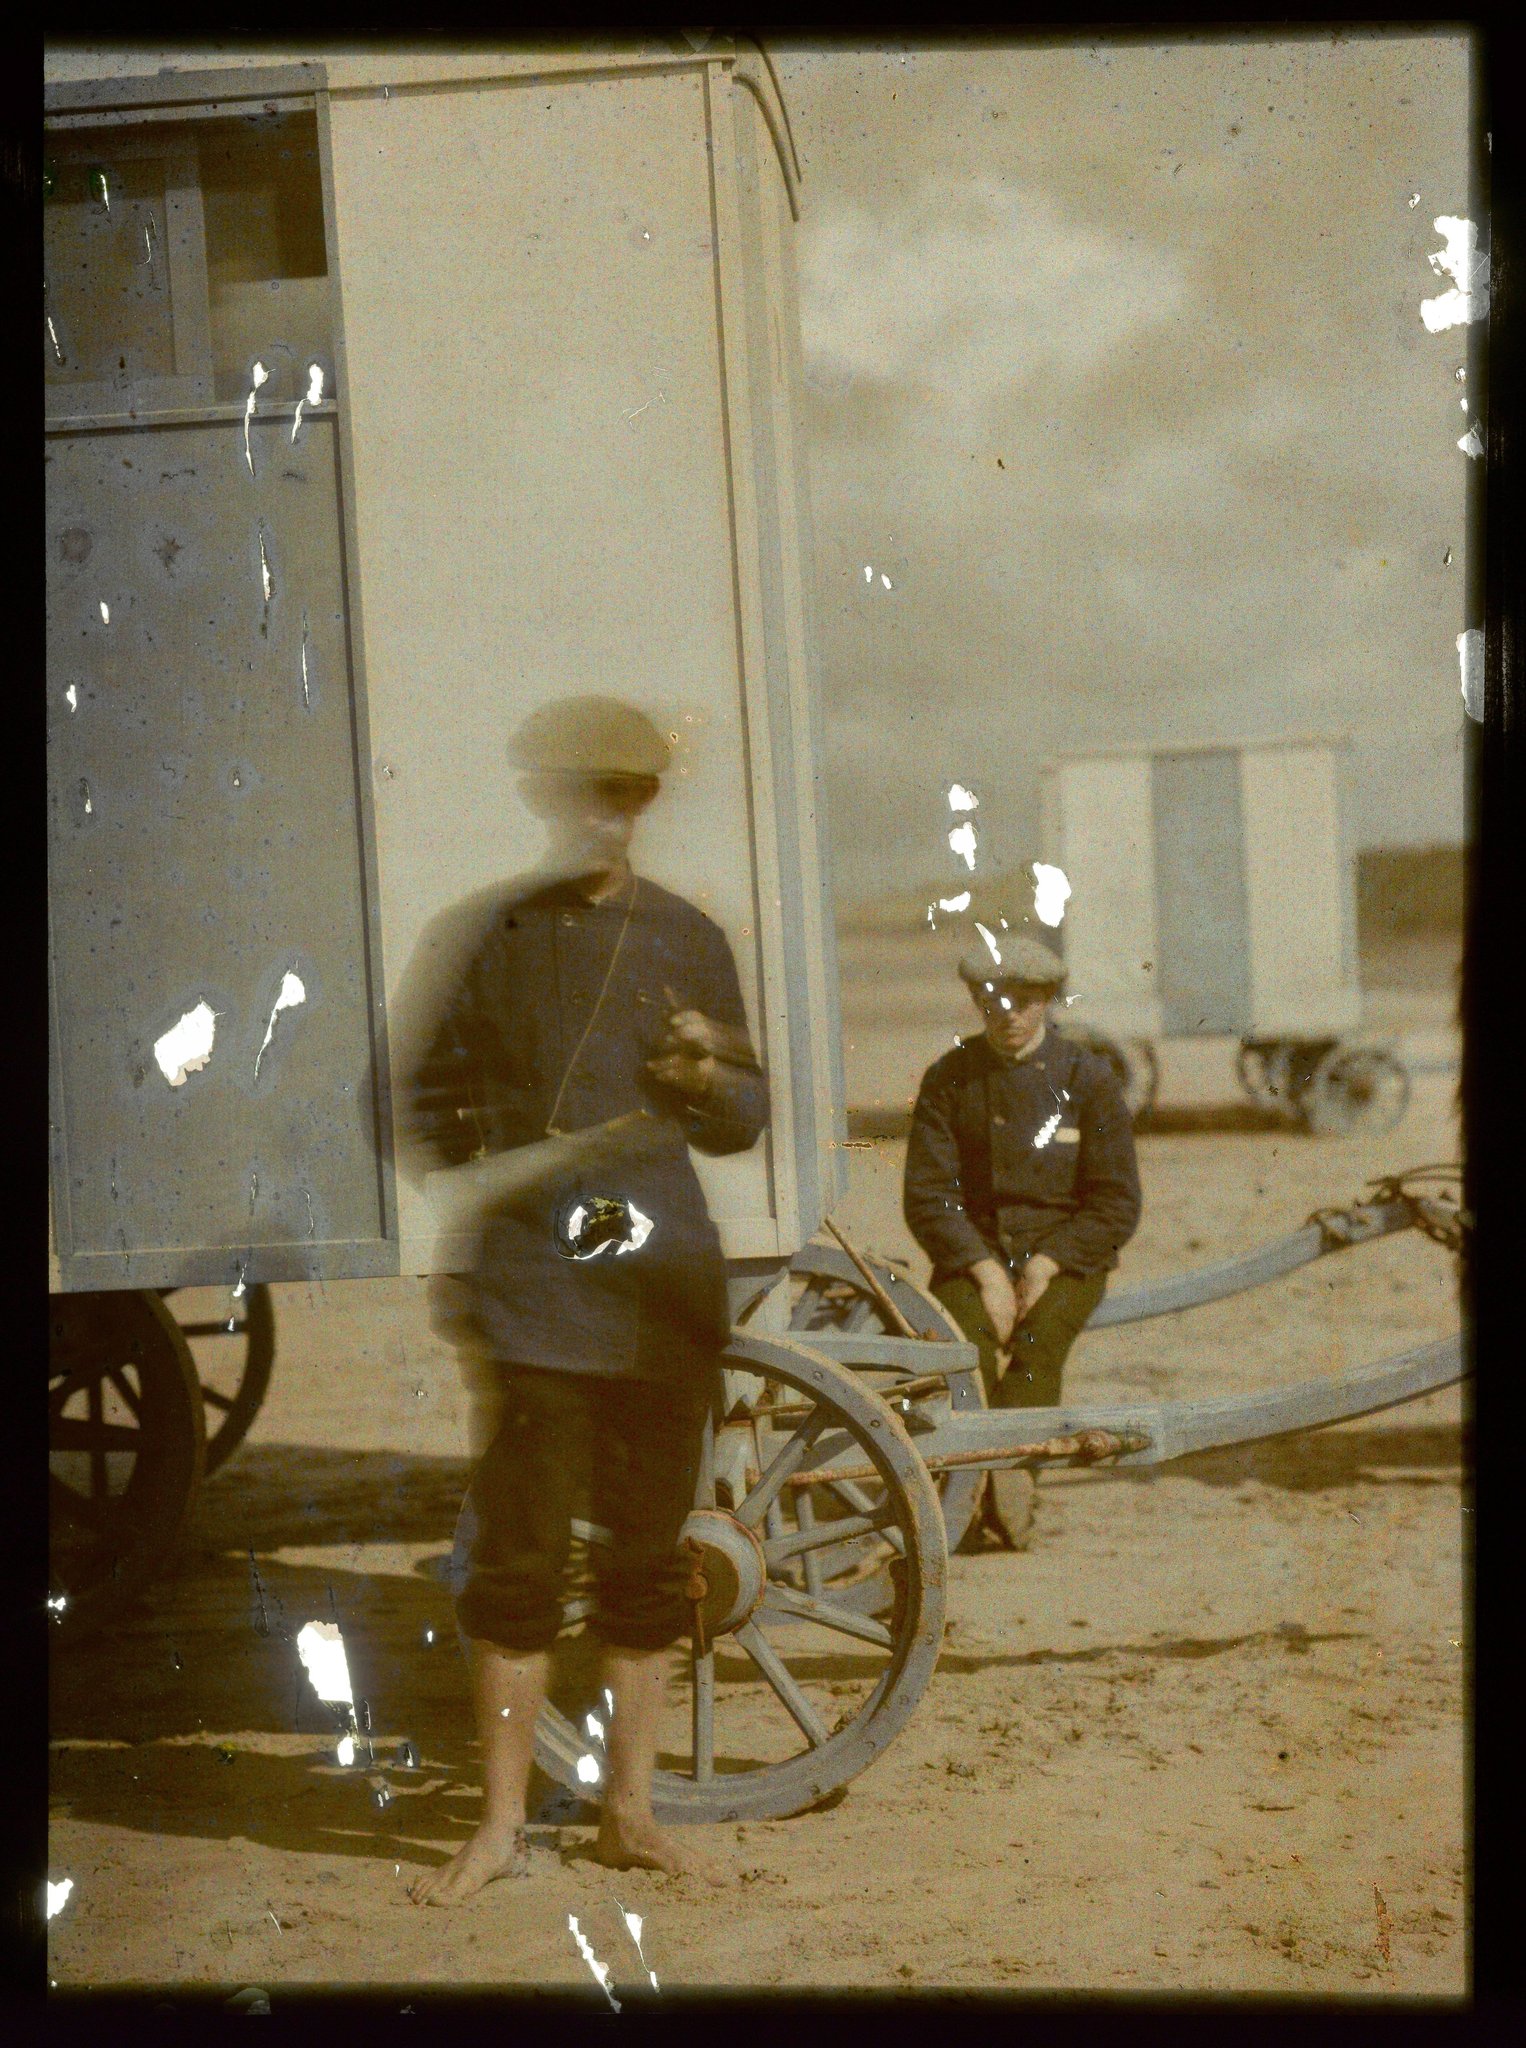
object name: color slide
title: Twee mannen bij twee blauwwit geschilderde badkoetsen op het strand bij Wijk aan Zee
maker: adolphe burdet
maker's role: fotograaf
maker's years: 1860-1940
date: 1907-1930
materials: glass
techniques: autochrome process, slide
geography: netherlands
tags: wijk aan zee